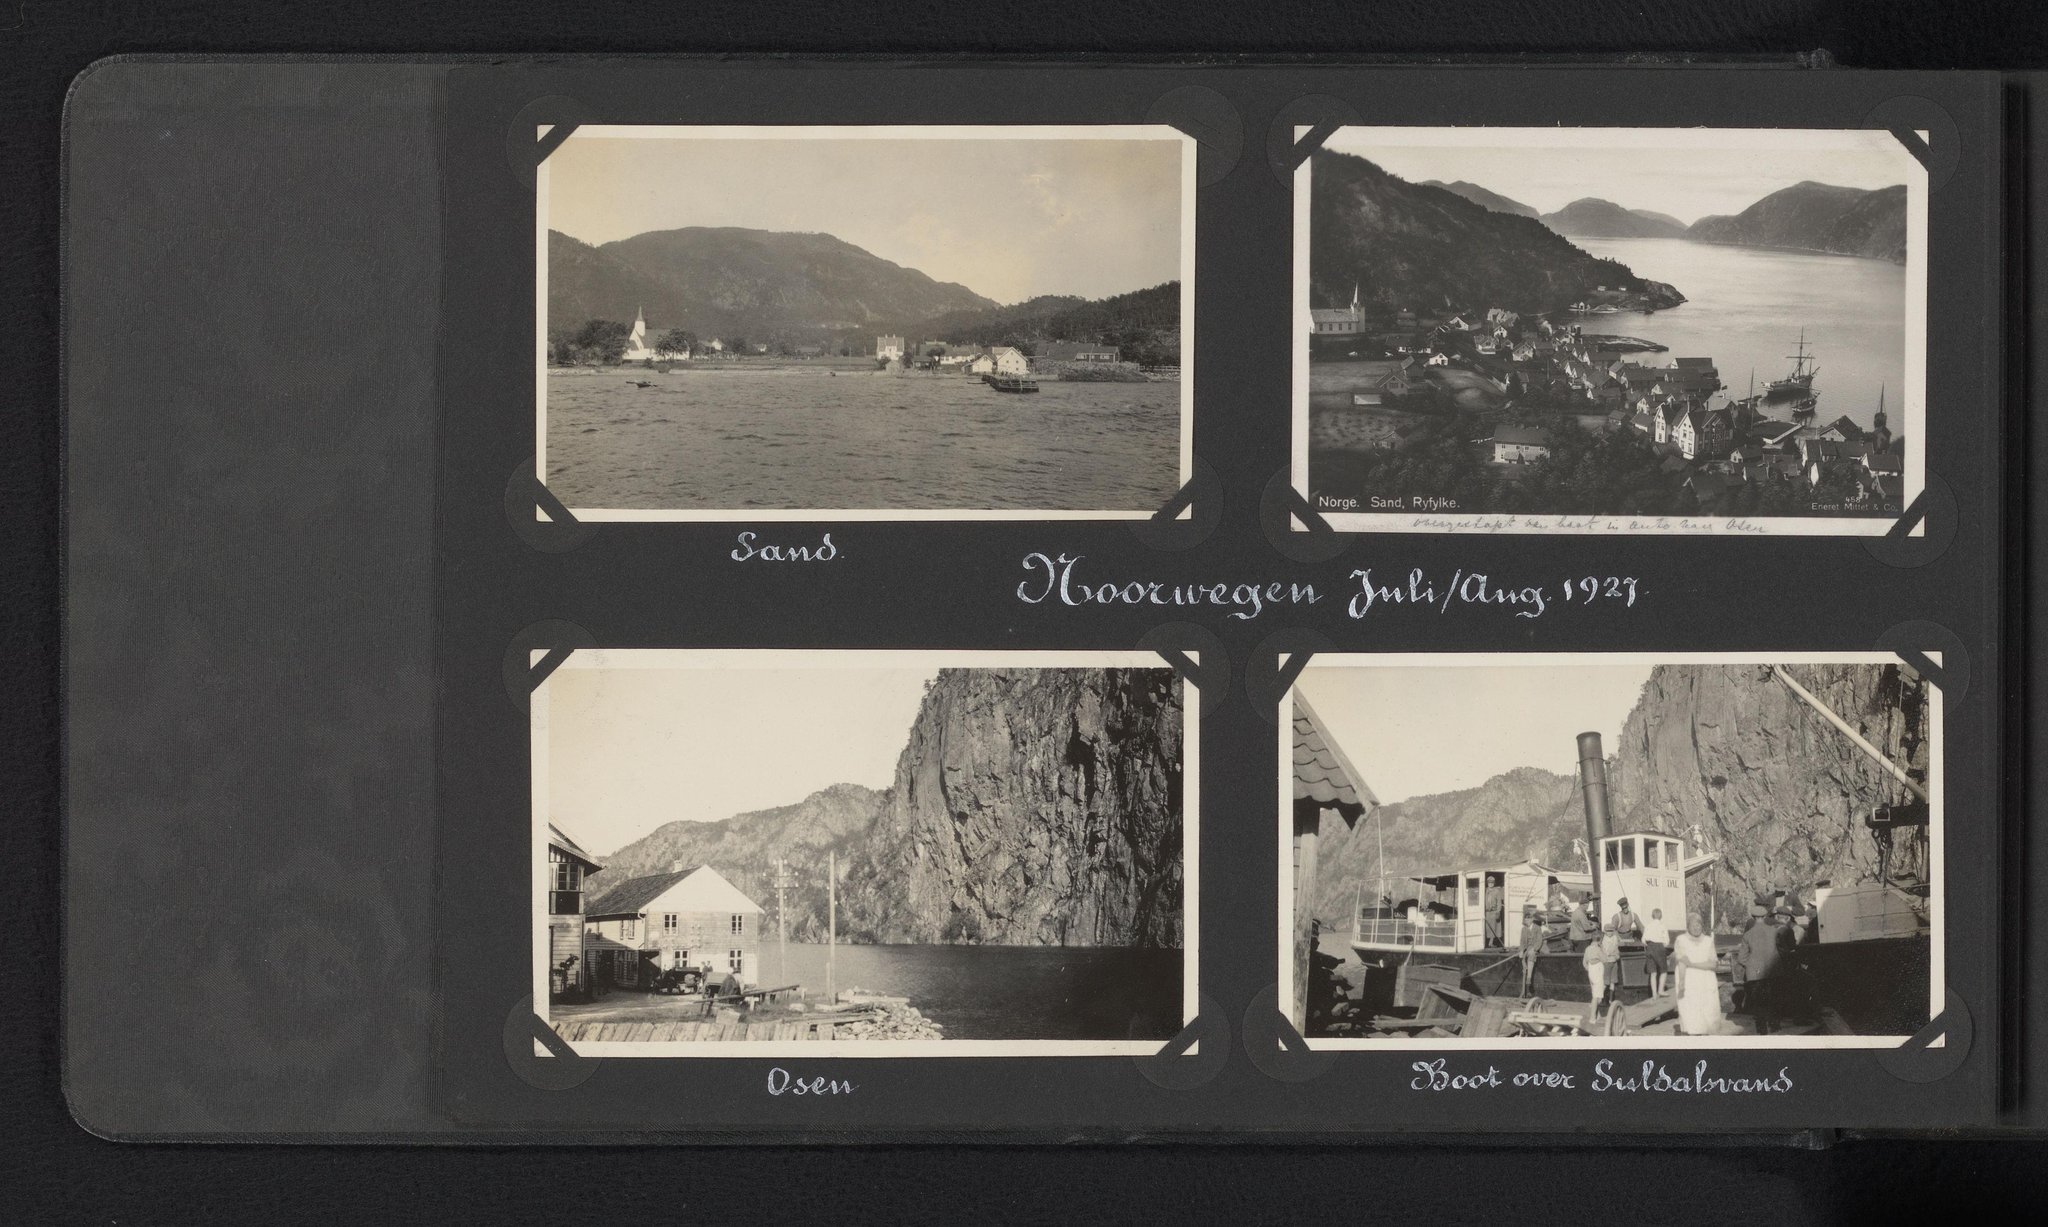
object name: photograph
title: Vier foto's, waarvan één prentbriefkaart, van plaatsen in Noorwegen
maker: hendrik herman van den berg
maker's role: amateurfotograaf, jurist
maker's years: 1875-1944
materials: paper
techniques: gelatin silver print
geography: norway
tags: fjord, sea loch, village, steamship, motorship, norway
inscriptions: inscription: ‘Sand’, inscription: ‘Boot over Suldalsvand’, inscription: ‘Osen’, inscription: ‘Overgestapt van boot in auto naar Osen’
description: Deze foto's maken deel uit van een album.